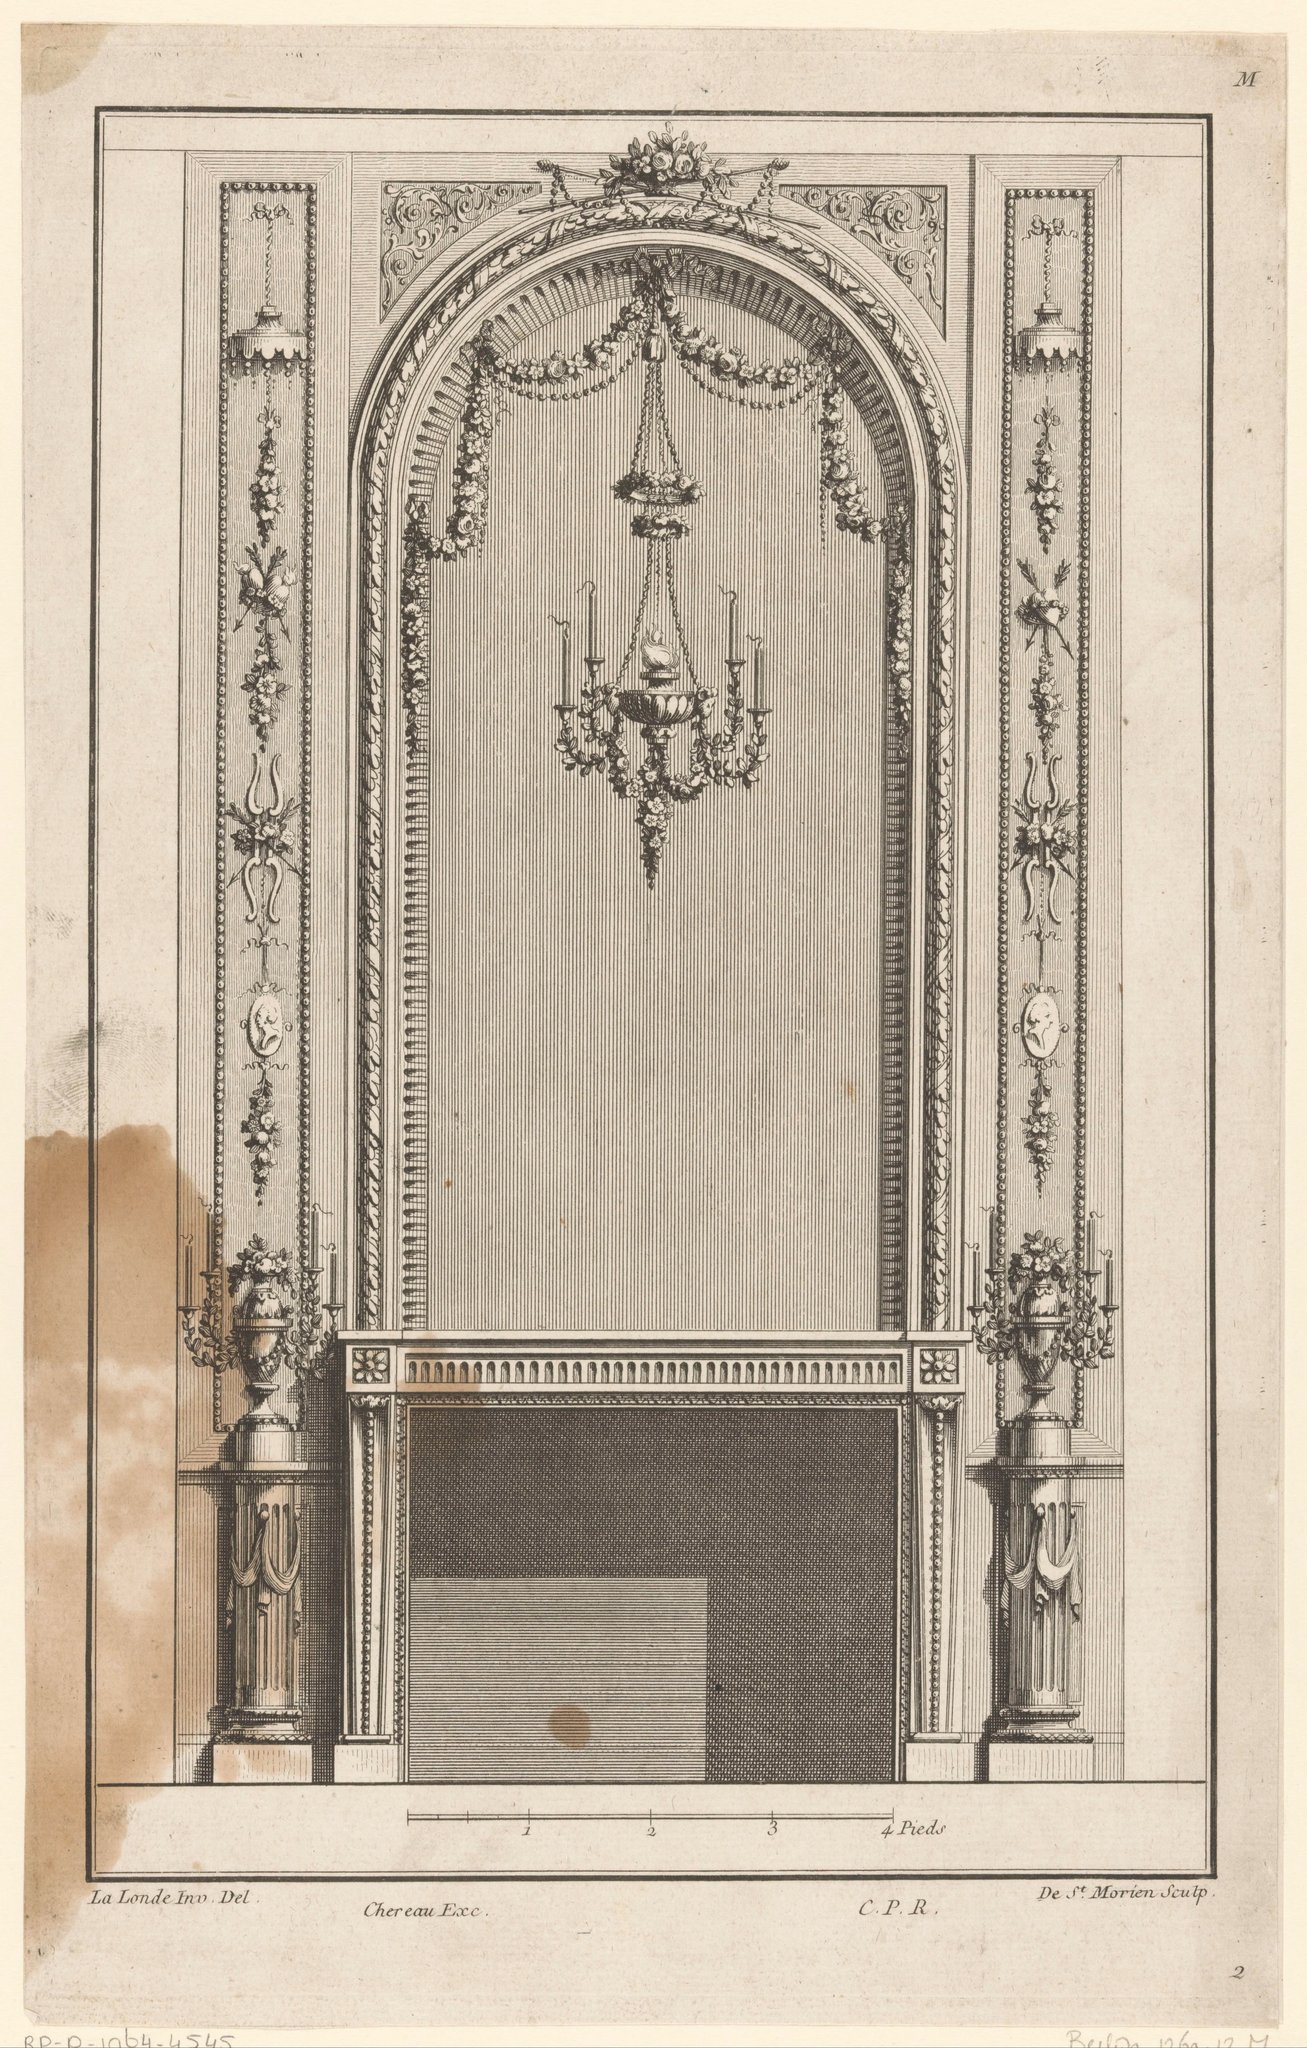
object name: ornament print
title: XIIe Cahier de l'Oeuvre M Cheminées avec leurs Trumeaux &c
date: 1784-1785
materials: paper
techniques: engraving, etching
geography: paris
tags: chandelier, candelabrum, open hearth, fire-place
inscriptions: collector's mark: Lugt 2760, collector's mark: Lugt 2228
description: Een geornamenteerde schouw met guirlandes en een vierarmige kroonluchter. Daarboven twee thyrsi en bloemen. Aan weerszijden van de schouw panelen met bloemen, harten, lieren, medaillons en twee vierarmige kandelaars.